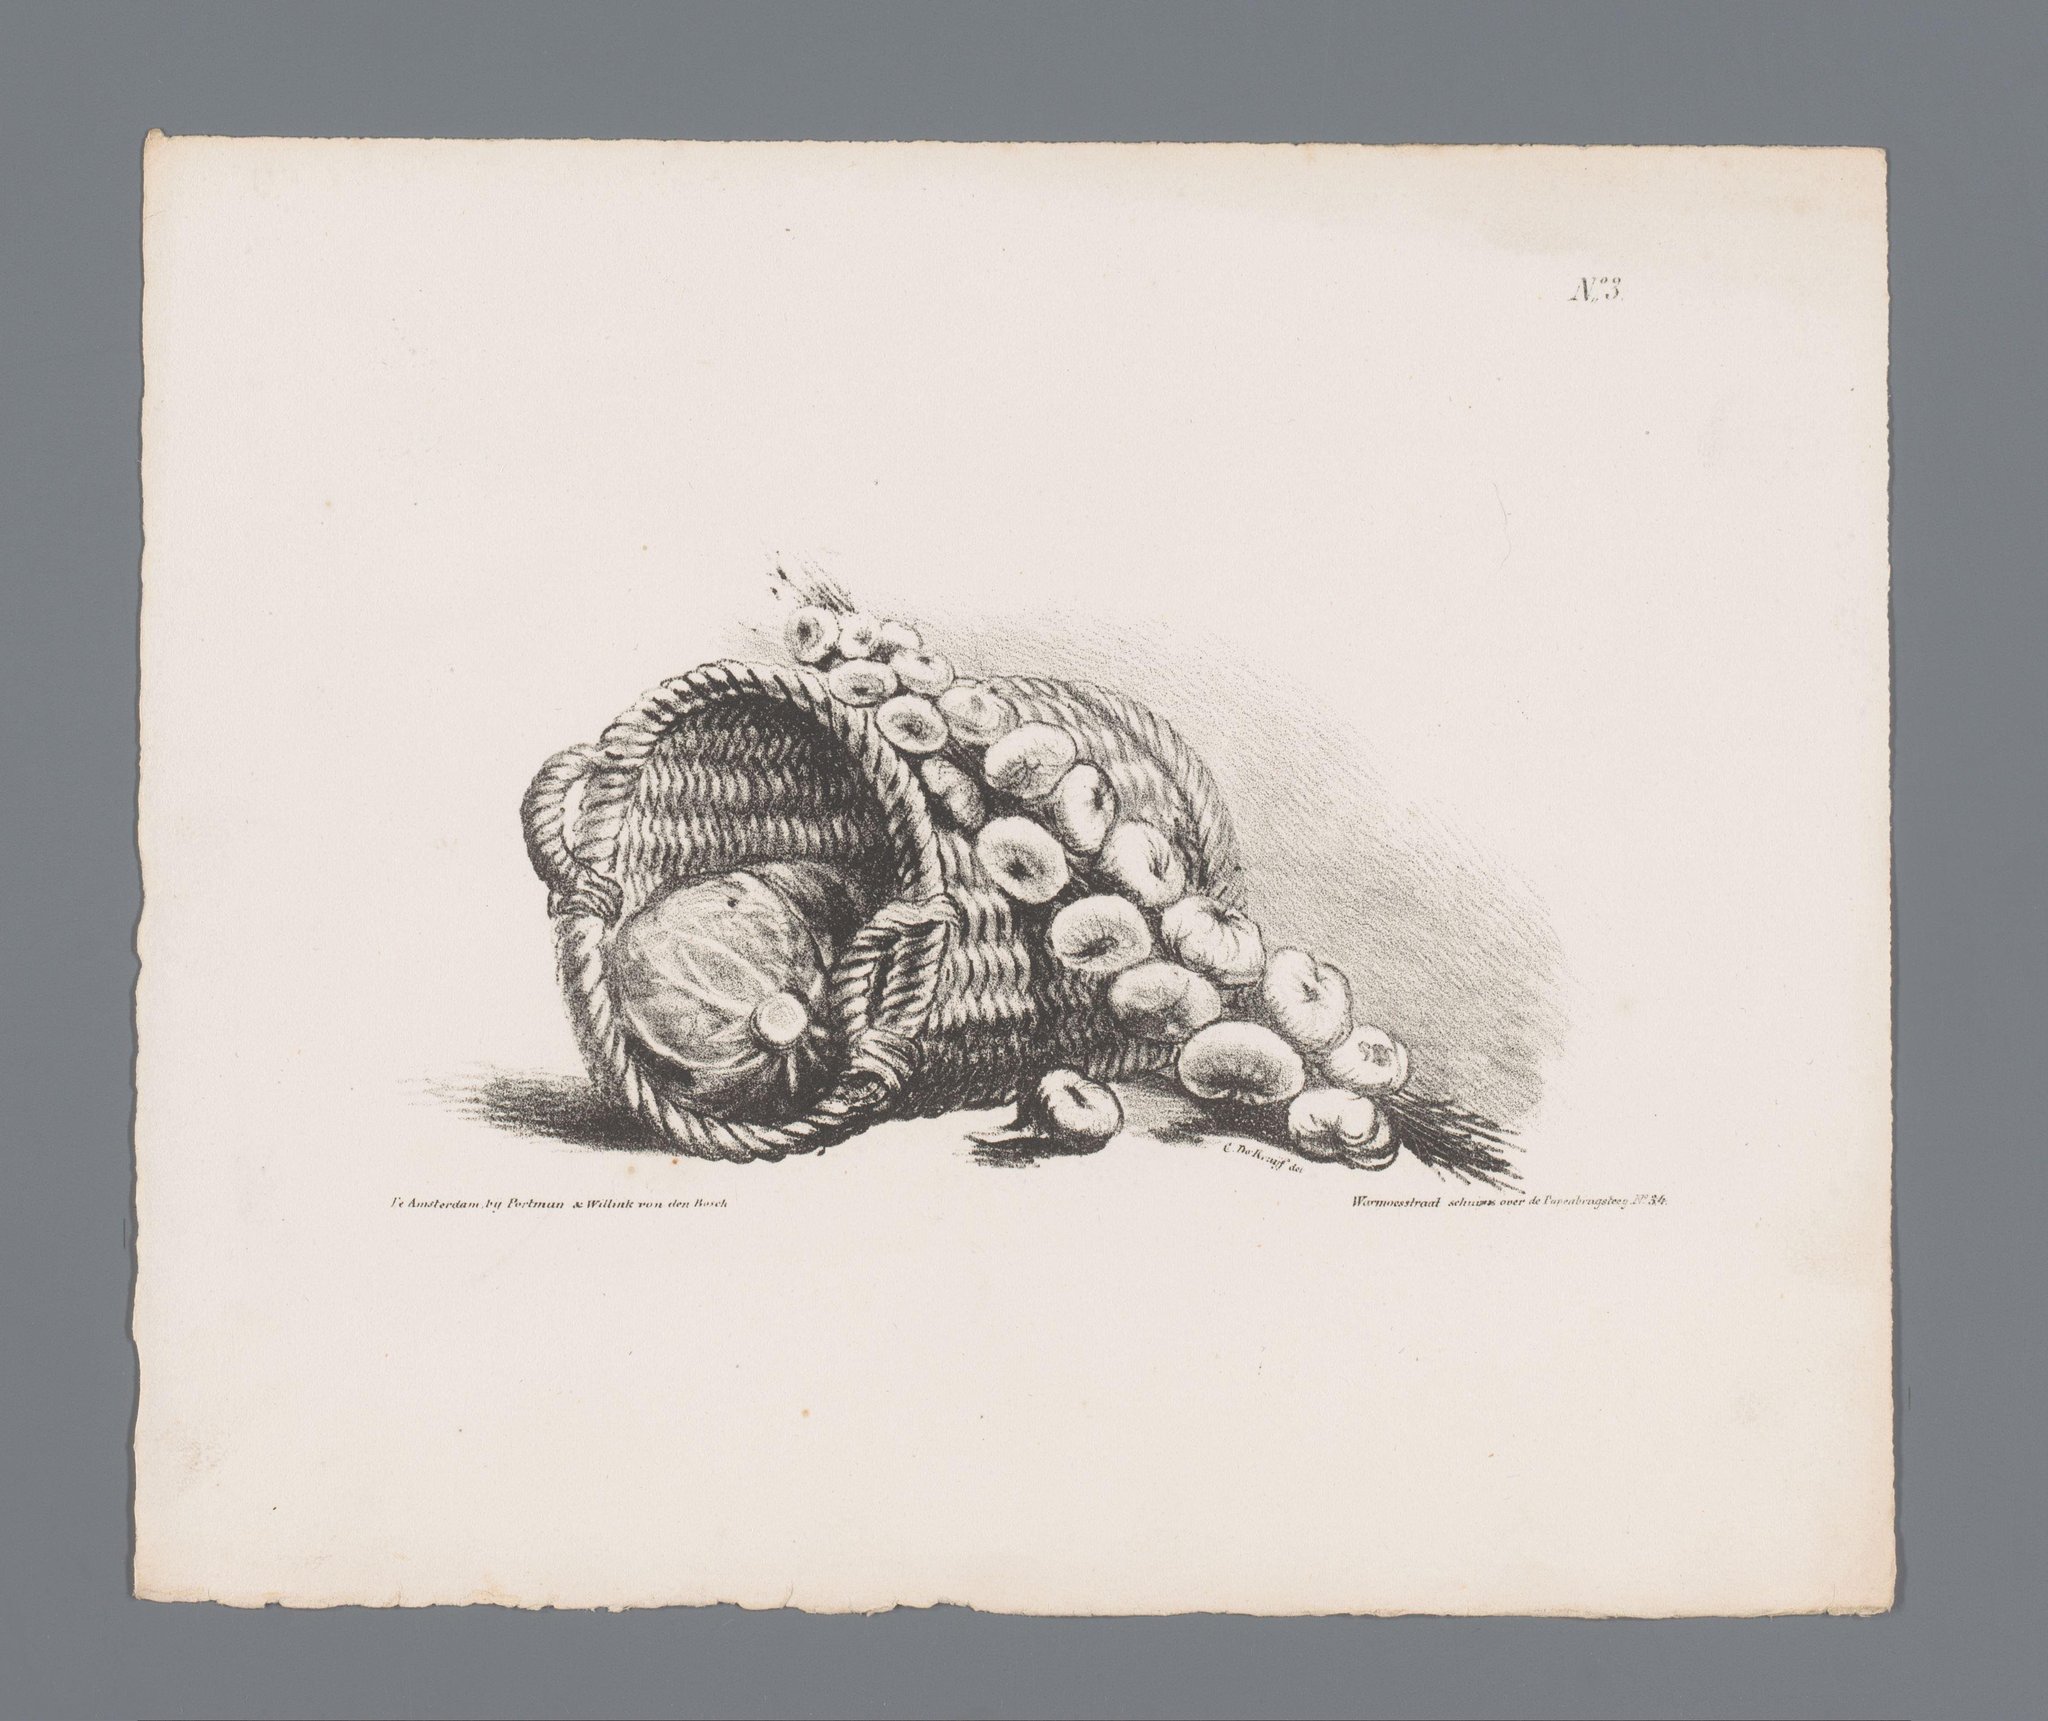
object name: print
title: Landschappen tot voorbeelden voor jonge kunstoeffenaren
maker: cornelis de kruyff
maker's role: draughtsman, print maker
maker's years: 1774-1828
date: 1809-1854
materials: paper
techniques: lithograph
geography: amsterdam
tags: container made of plant material other than wood: basket, plants and herbs: garlic, plants and herbs: cabbage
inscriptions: collector's mark: Lugt 2228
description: Deze prent maakt deel uit van een serie. Alle prenten zijn op dezelfde wijze rechtsboven genummerd. Linksonder: 'Te Amsterdam, bij Portman & Willink van den Bosch'. Rechtsonder: 'Warmoesstraat schuins over de Papenburgsteeg no. 34'. Midden onder: 'C. de Kruijf del.' Zie: RP-P-1892-A-16967 t/m RP-P-1892-A-16973.